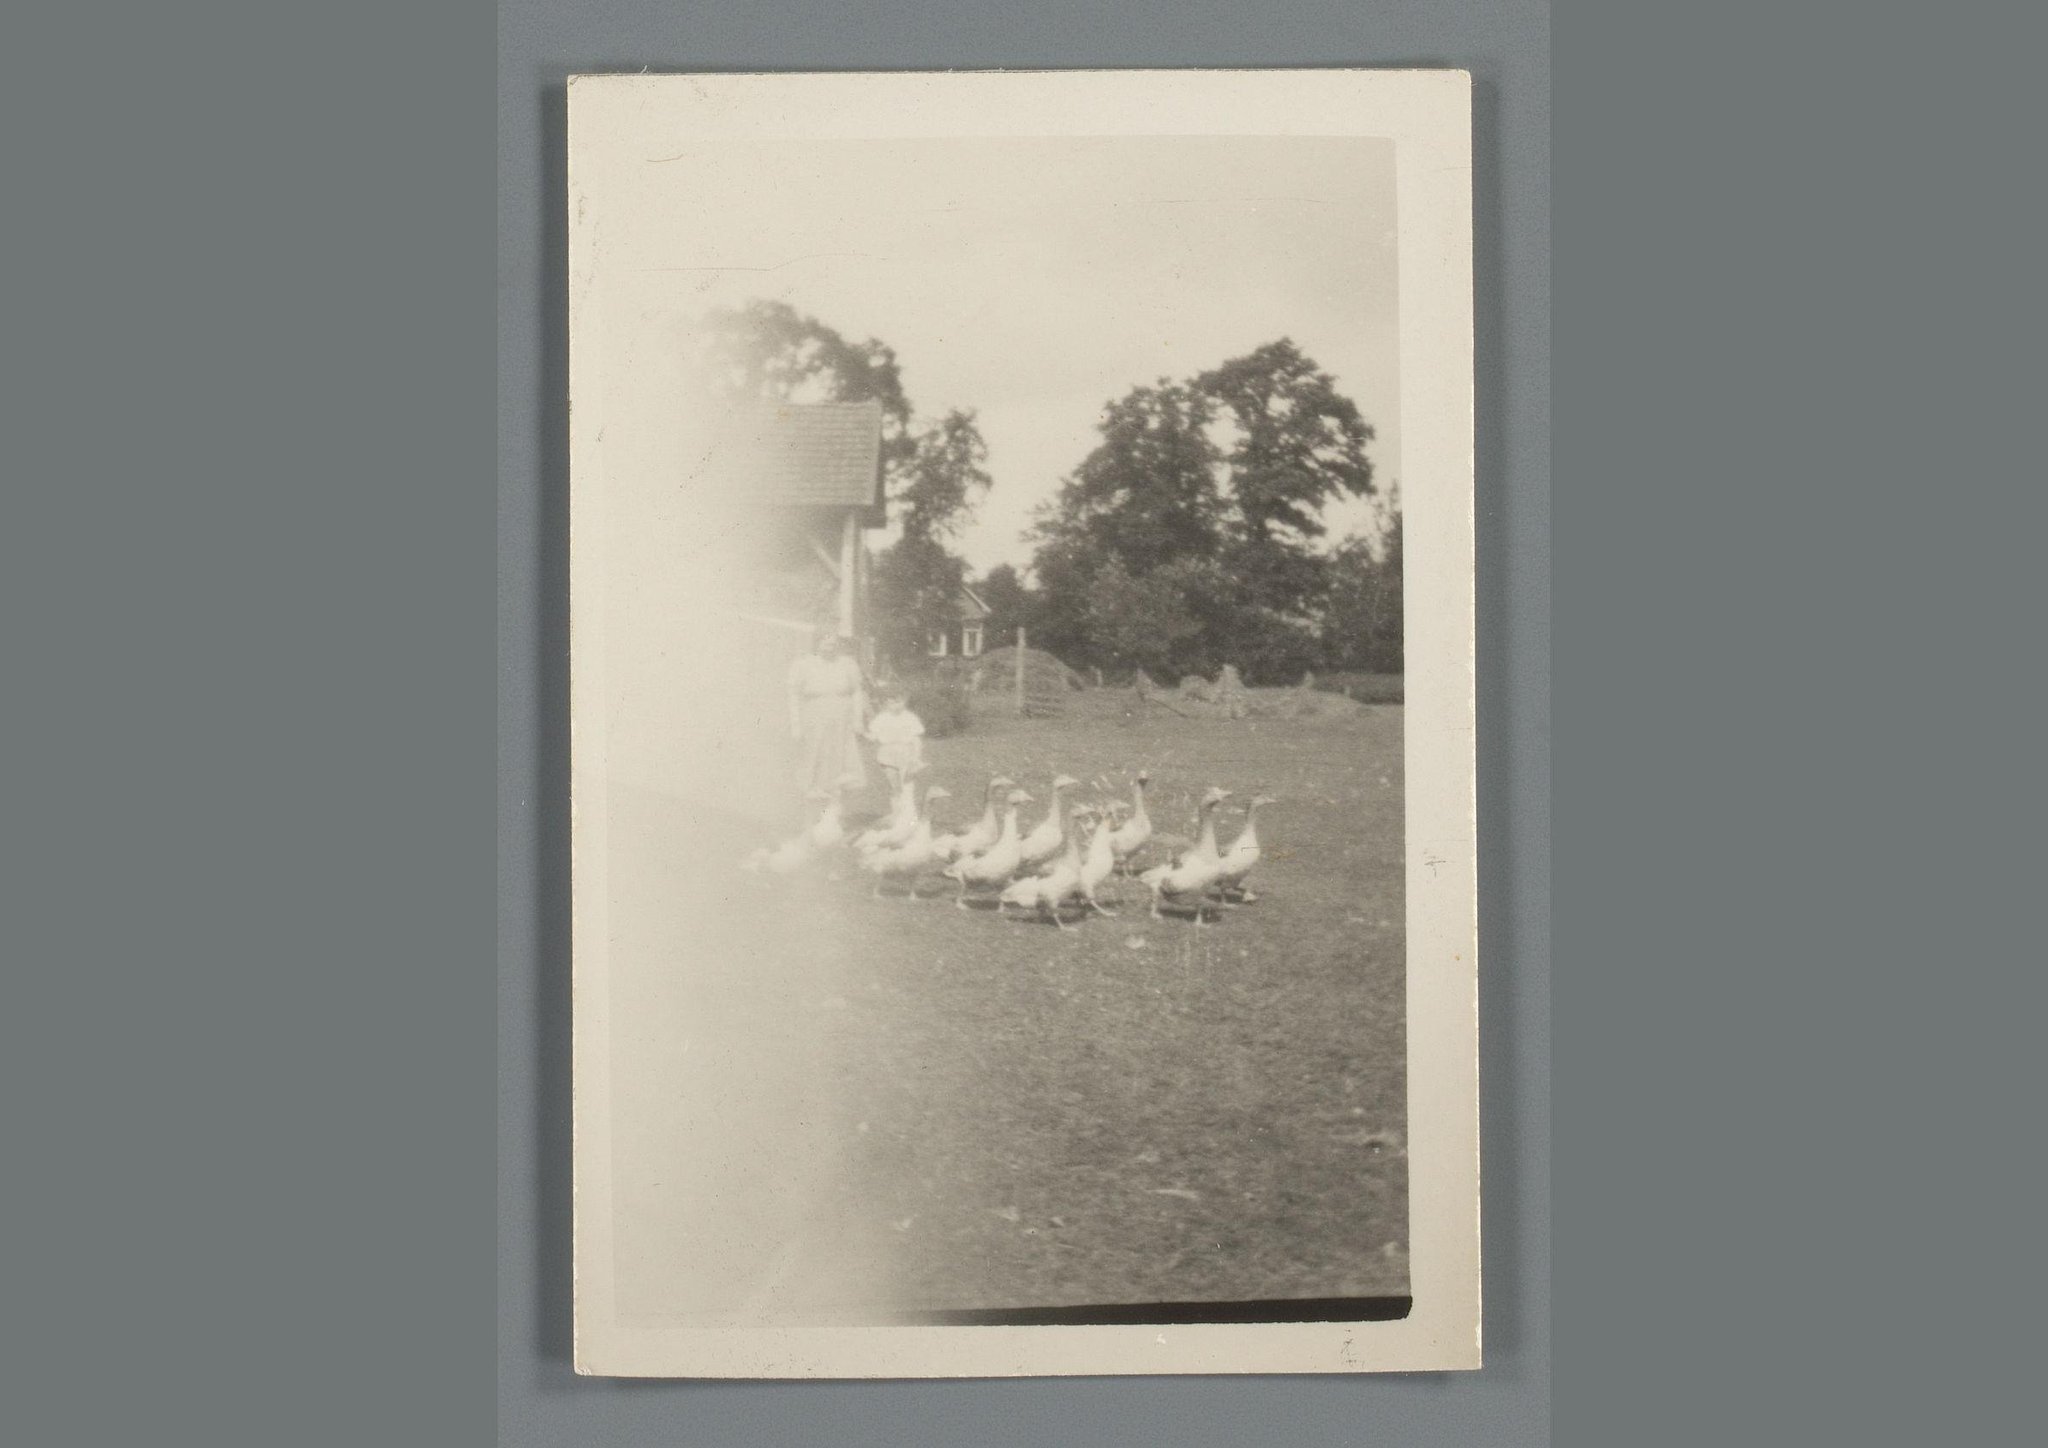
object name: photograph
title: Vrouw en een kind bij een groep ganzen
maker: Anonymous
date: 1920-1950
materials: paper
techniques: gelatin silver print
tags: geese (domestic waterbirds), mother and child(ren), woman and child(ren) (family group)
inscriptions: number: ‘17’